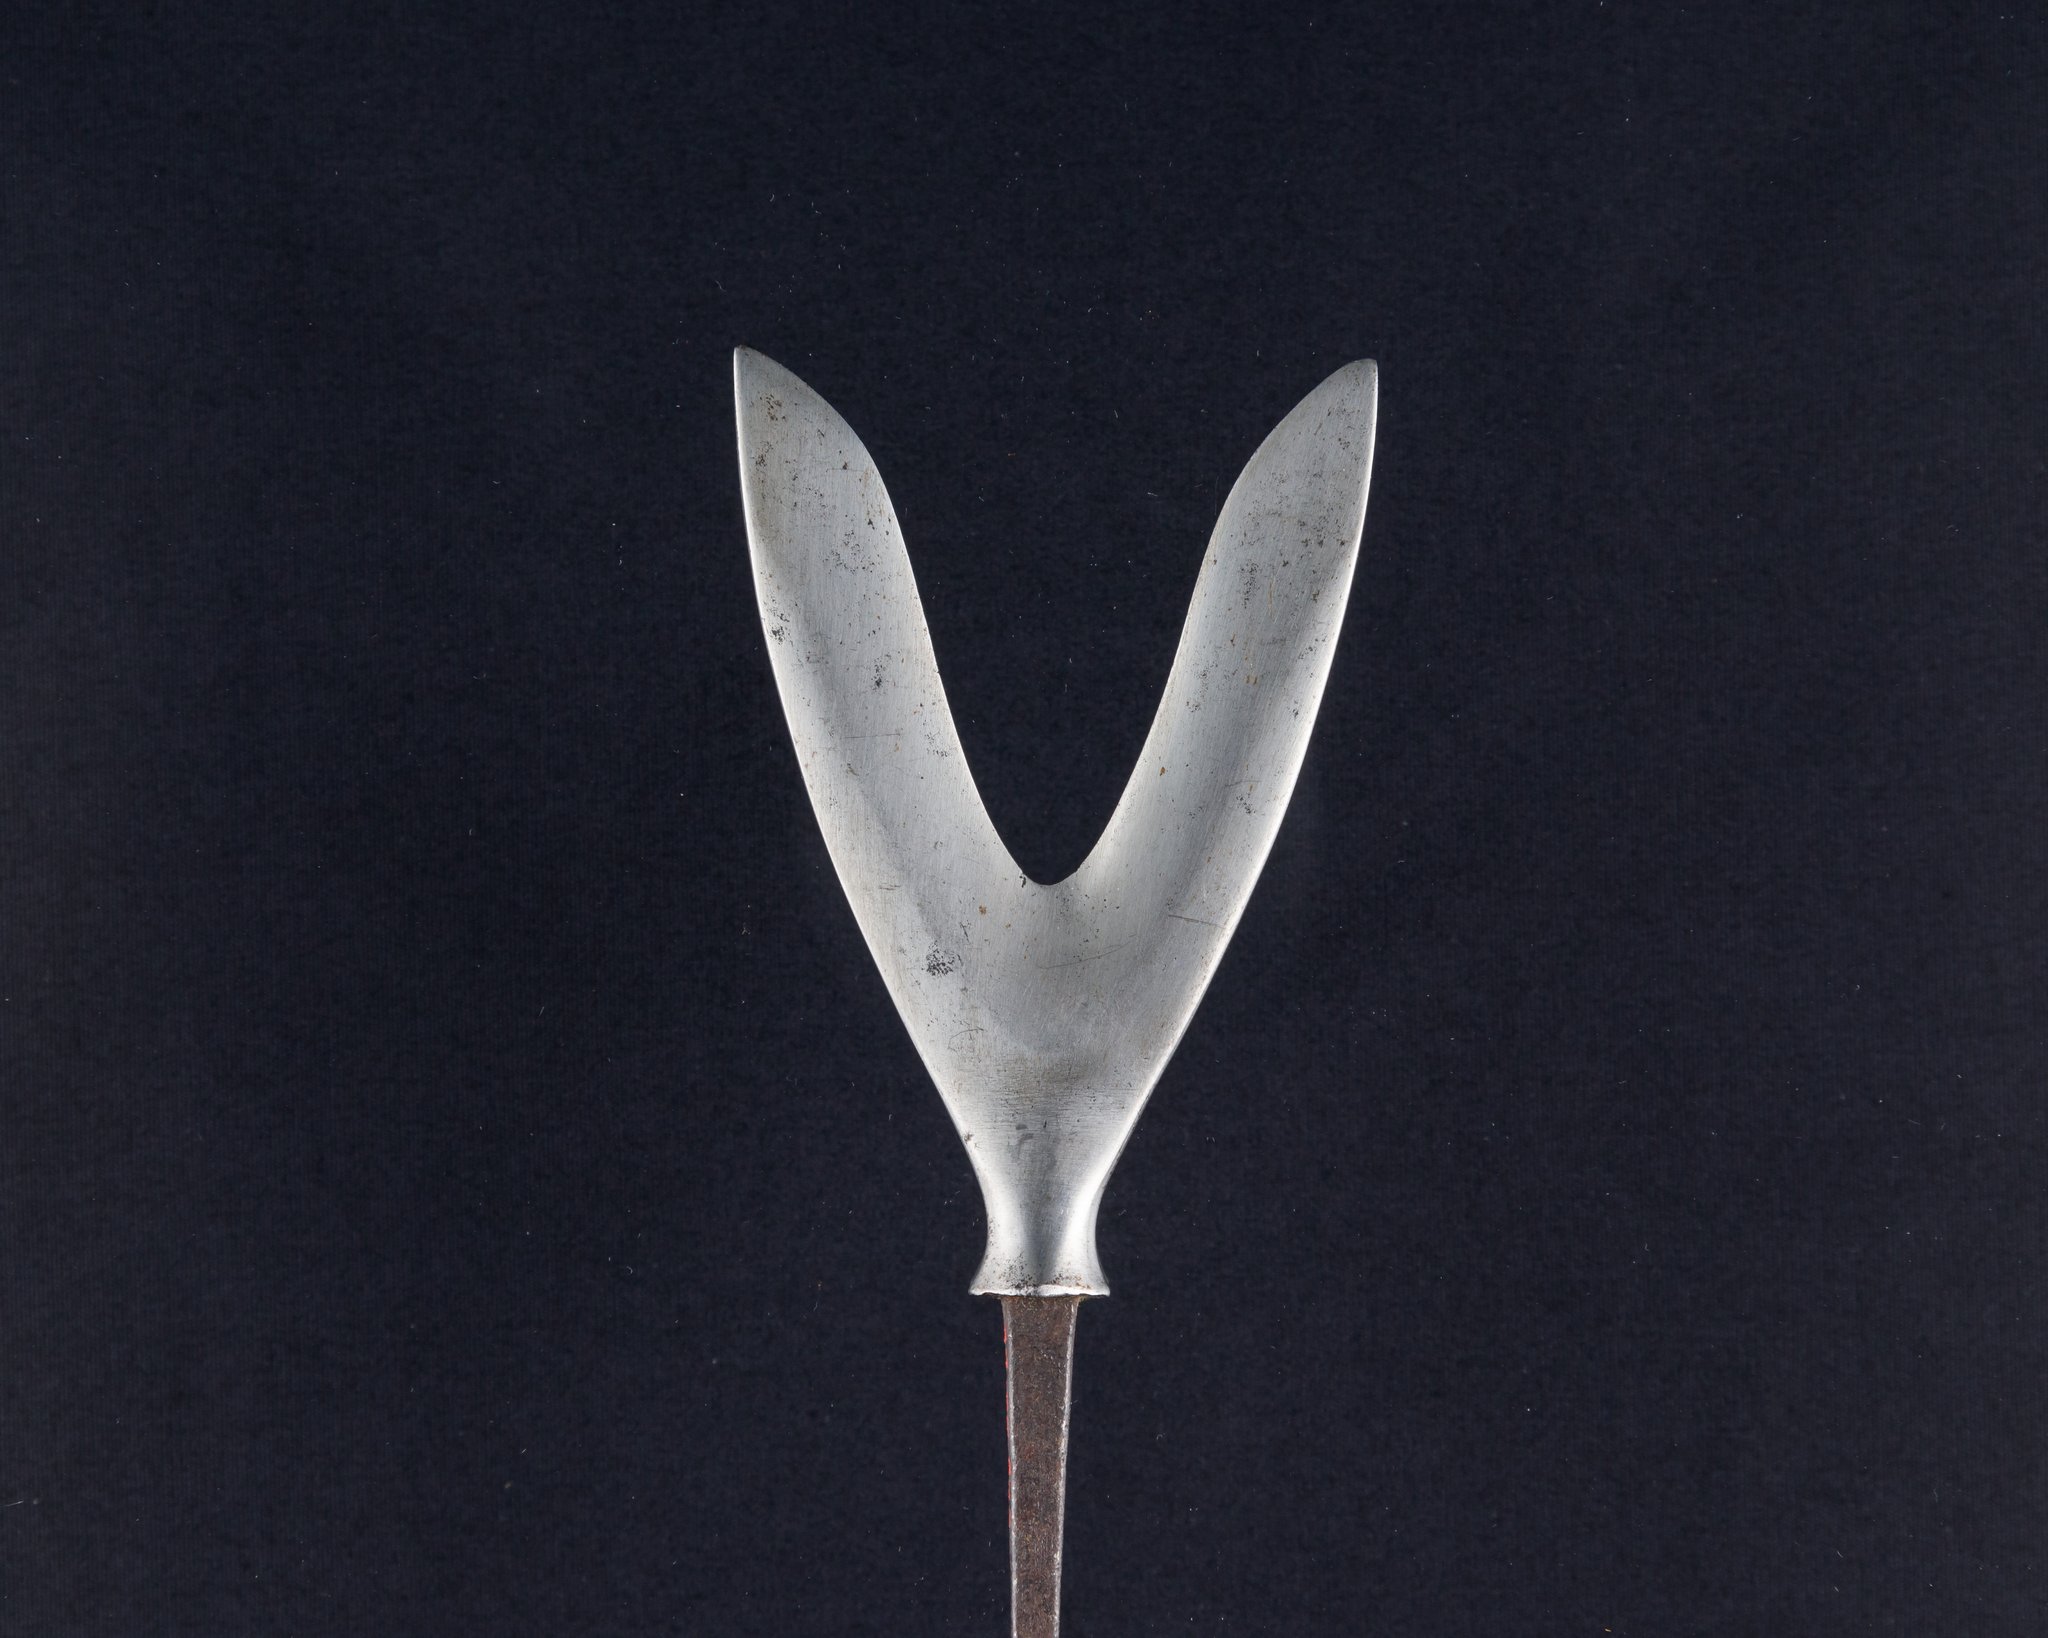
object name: arrowhead i yanone i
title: Arrowhead (Yanone)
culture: japanese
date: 1701-1800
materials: steel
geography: japan